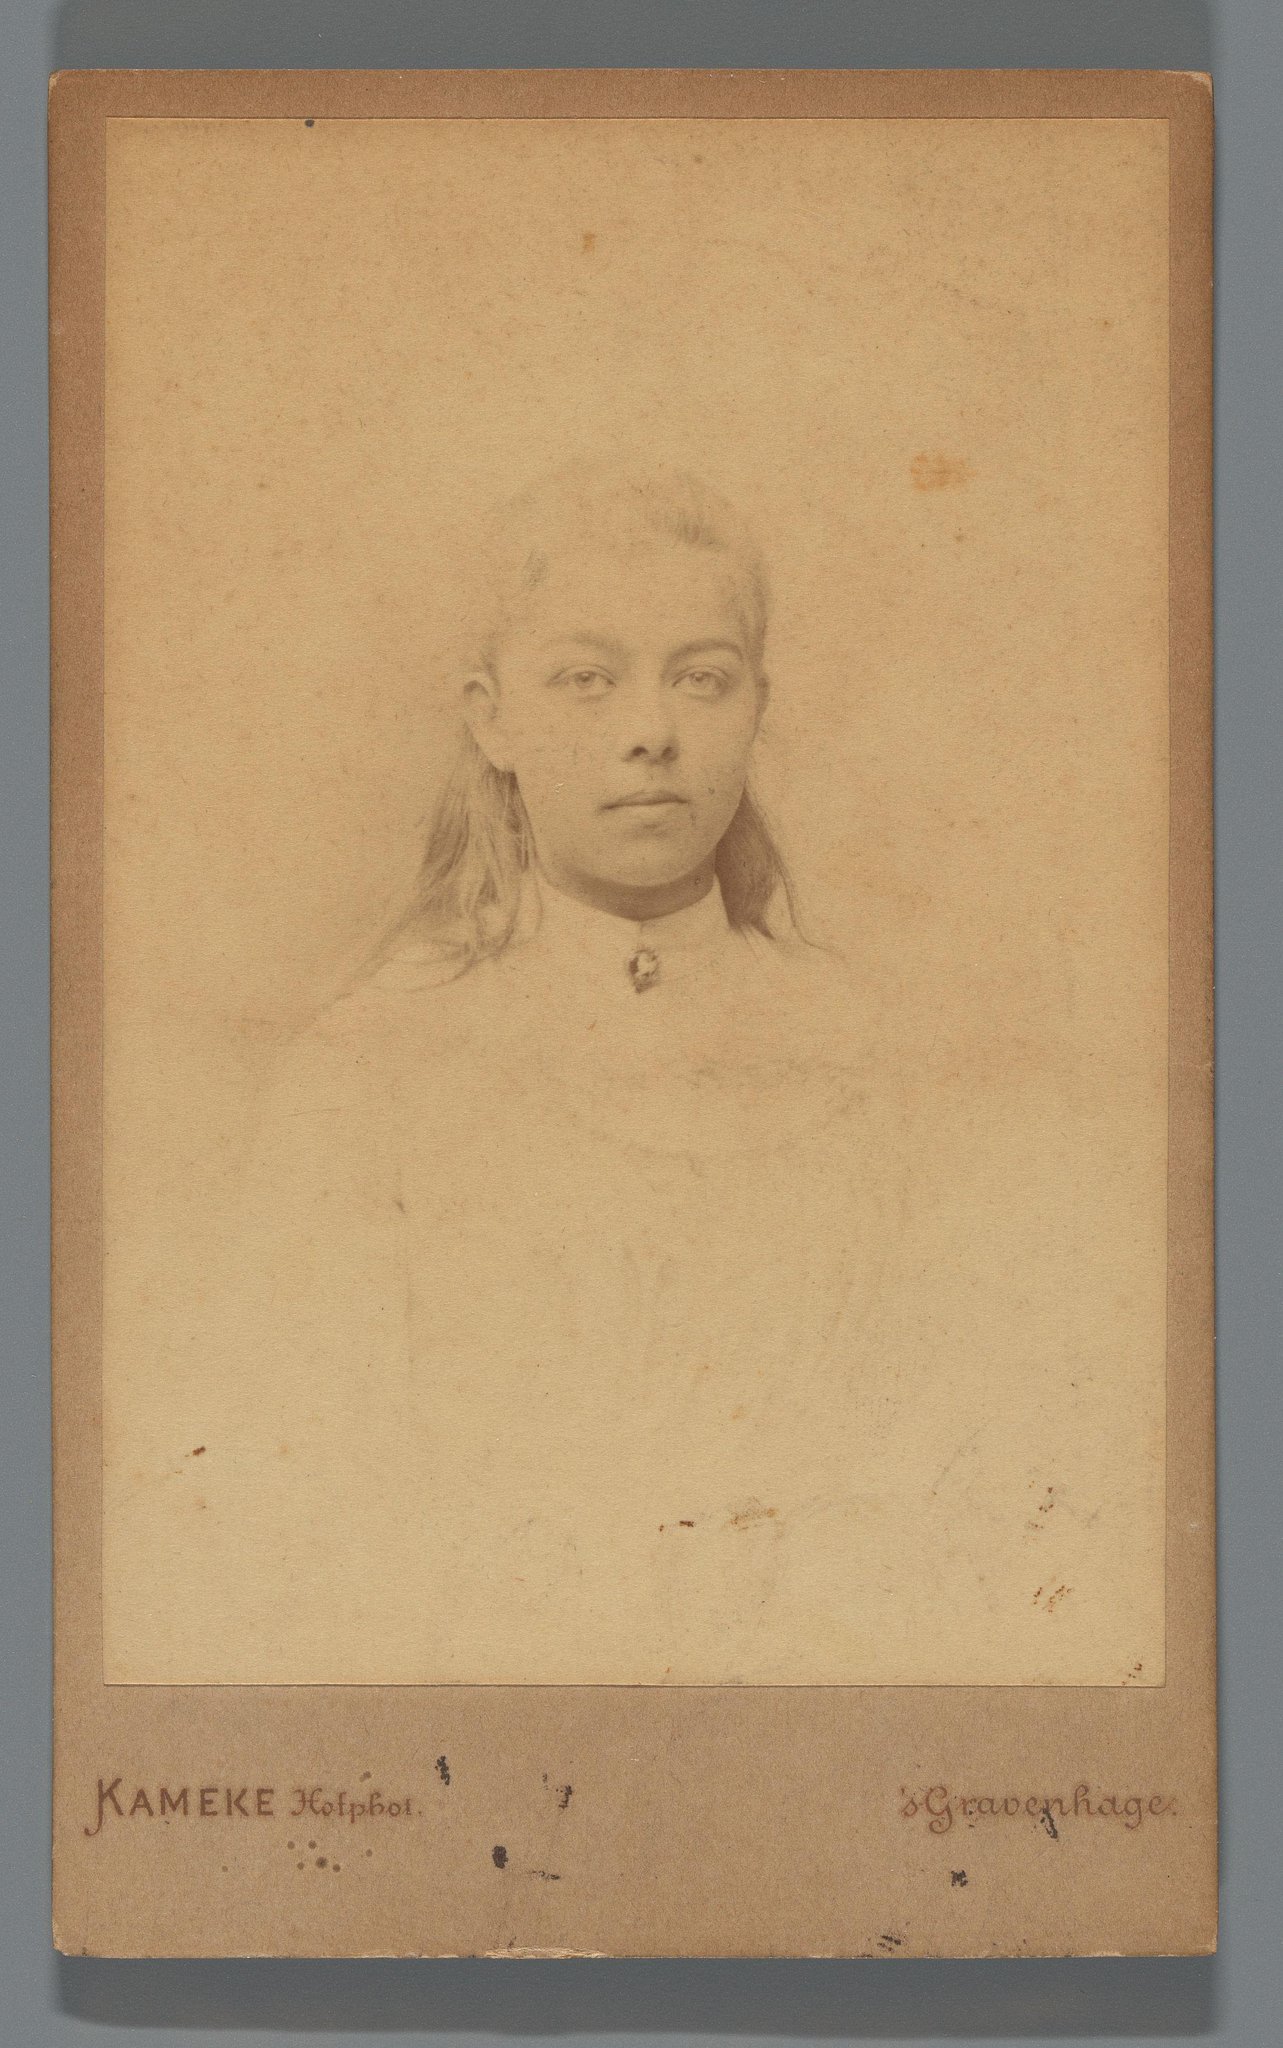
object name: photograph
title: Portret van A.C.M. Geertsema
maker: kameke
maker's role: painter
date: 1855-1910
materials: cardboard, photographic support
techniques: albumen print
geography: the hague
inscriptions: name: ‘KAMEKE / Kunstschilder en hofphotograph / 's-Gravenhage / Javastr. 20.’, name: ‘KAMEKE Hofphot. 's-Gravenhage’